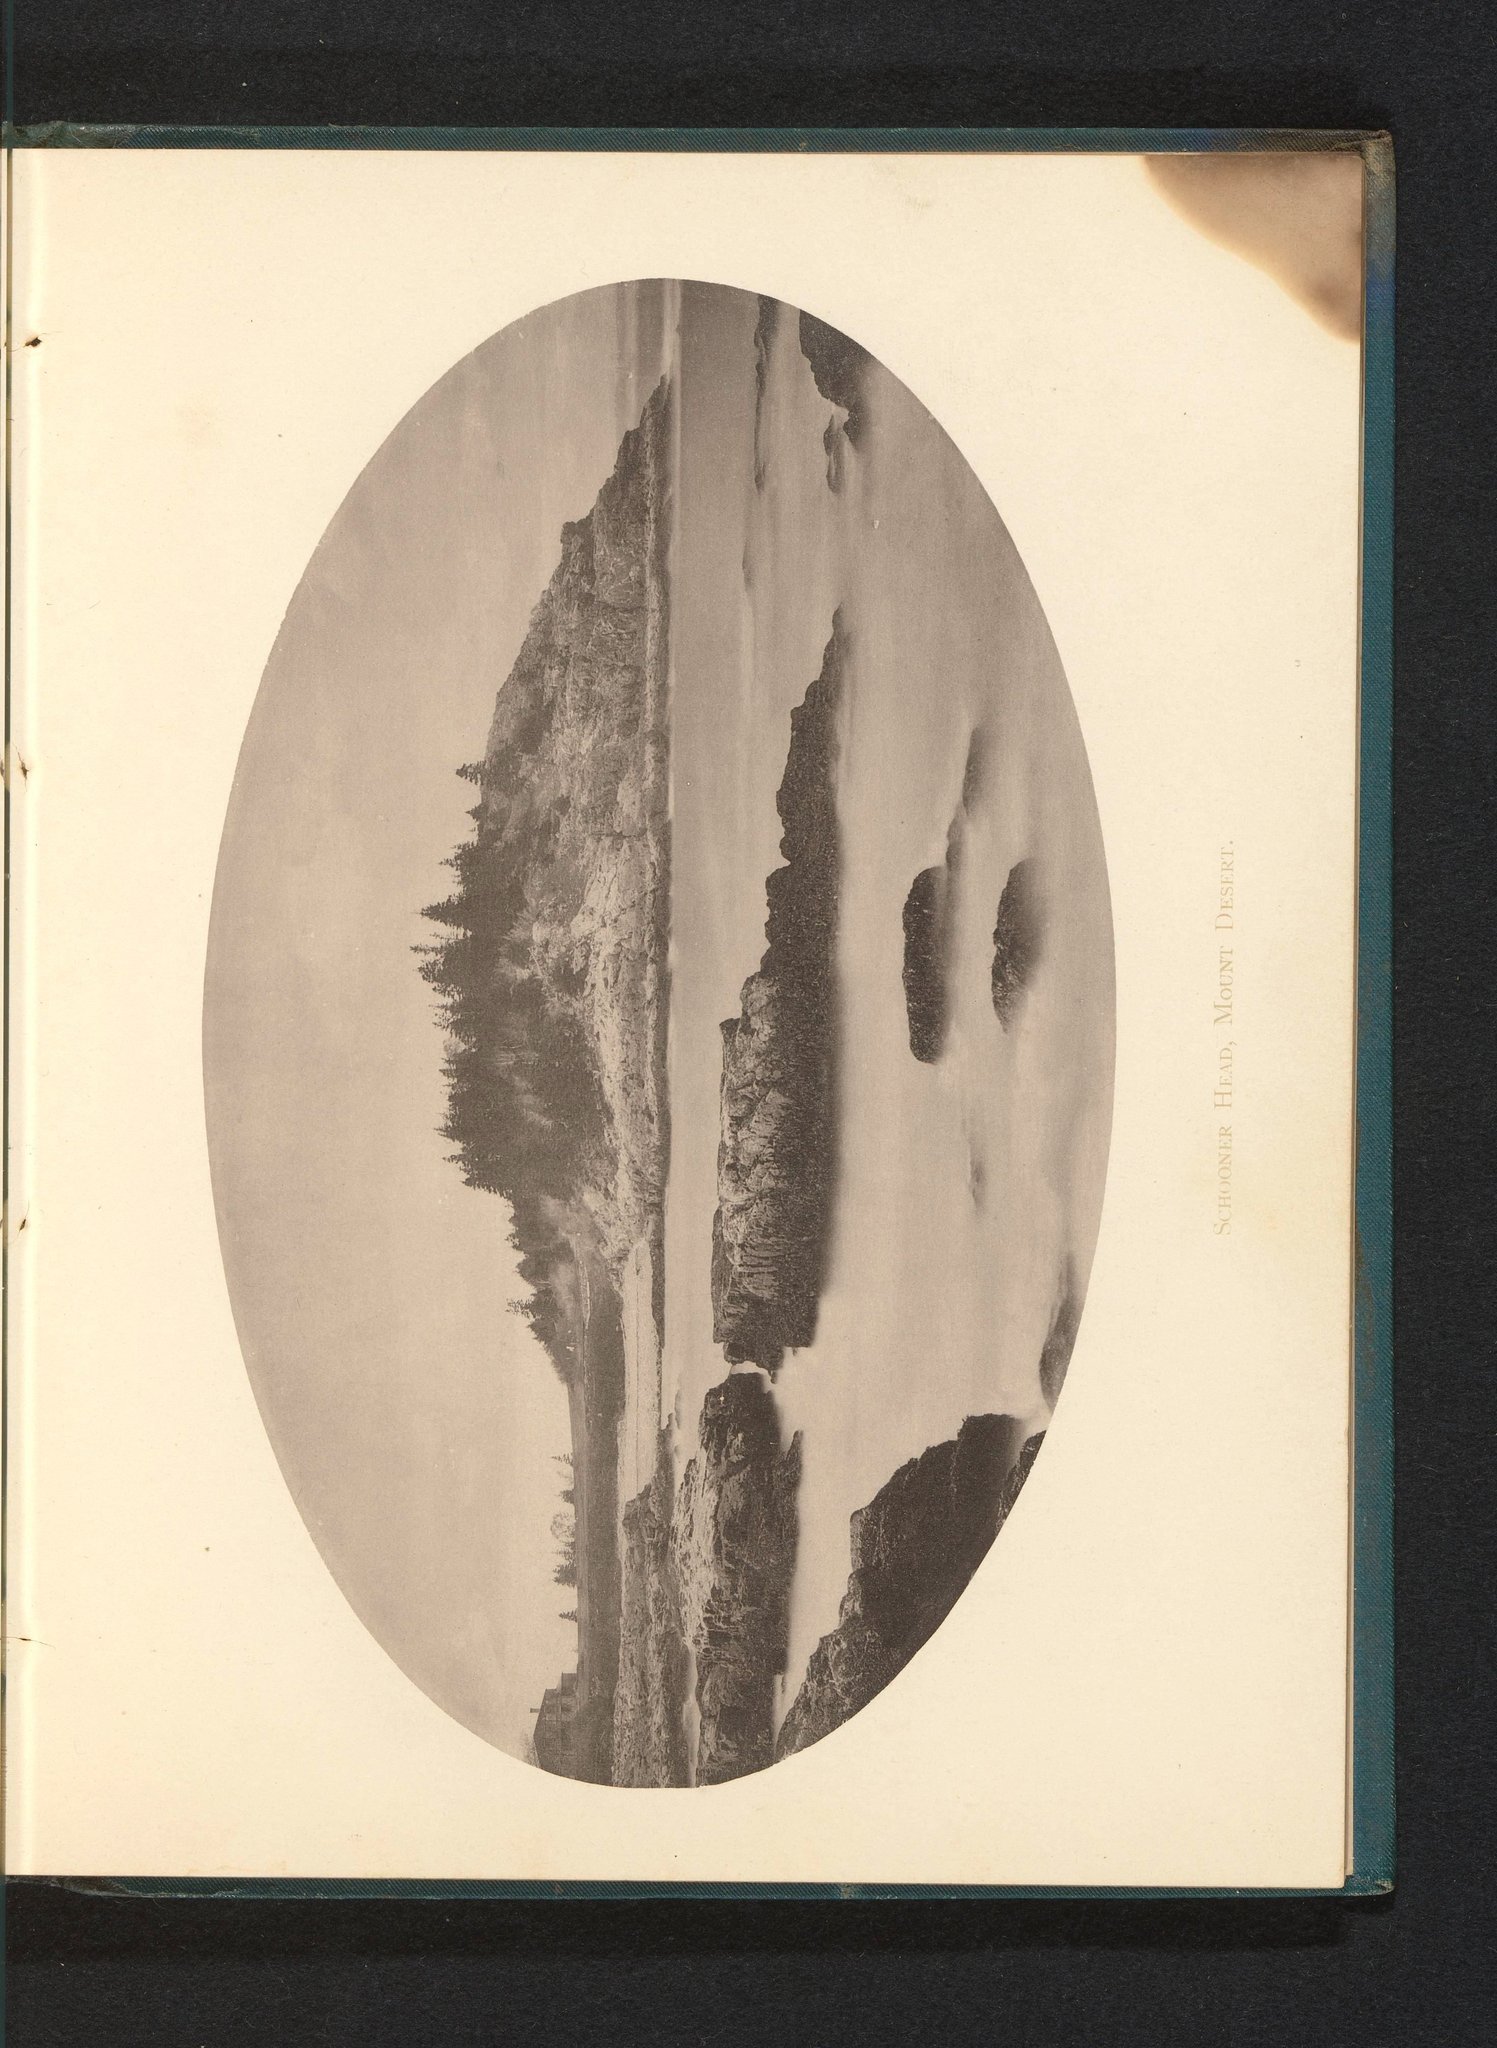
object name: page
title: Gezicht op Schooner Head op Mount Desert Island, Maine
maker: Anonymous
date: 1875-1880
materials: paper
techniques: photograph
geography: schooner head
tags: cape (coast)